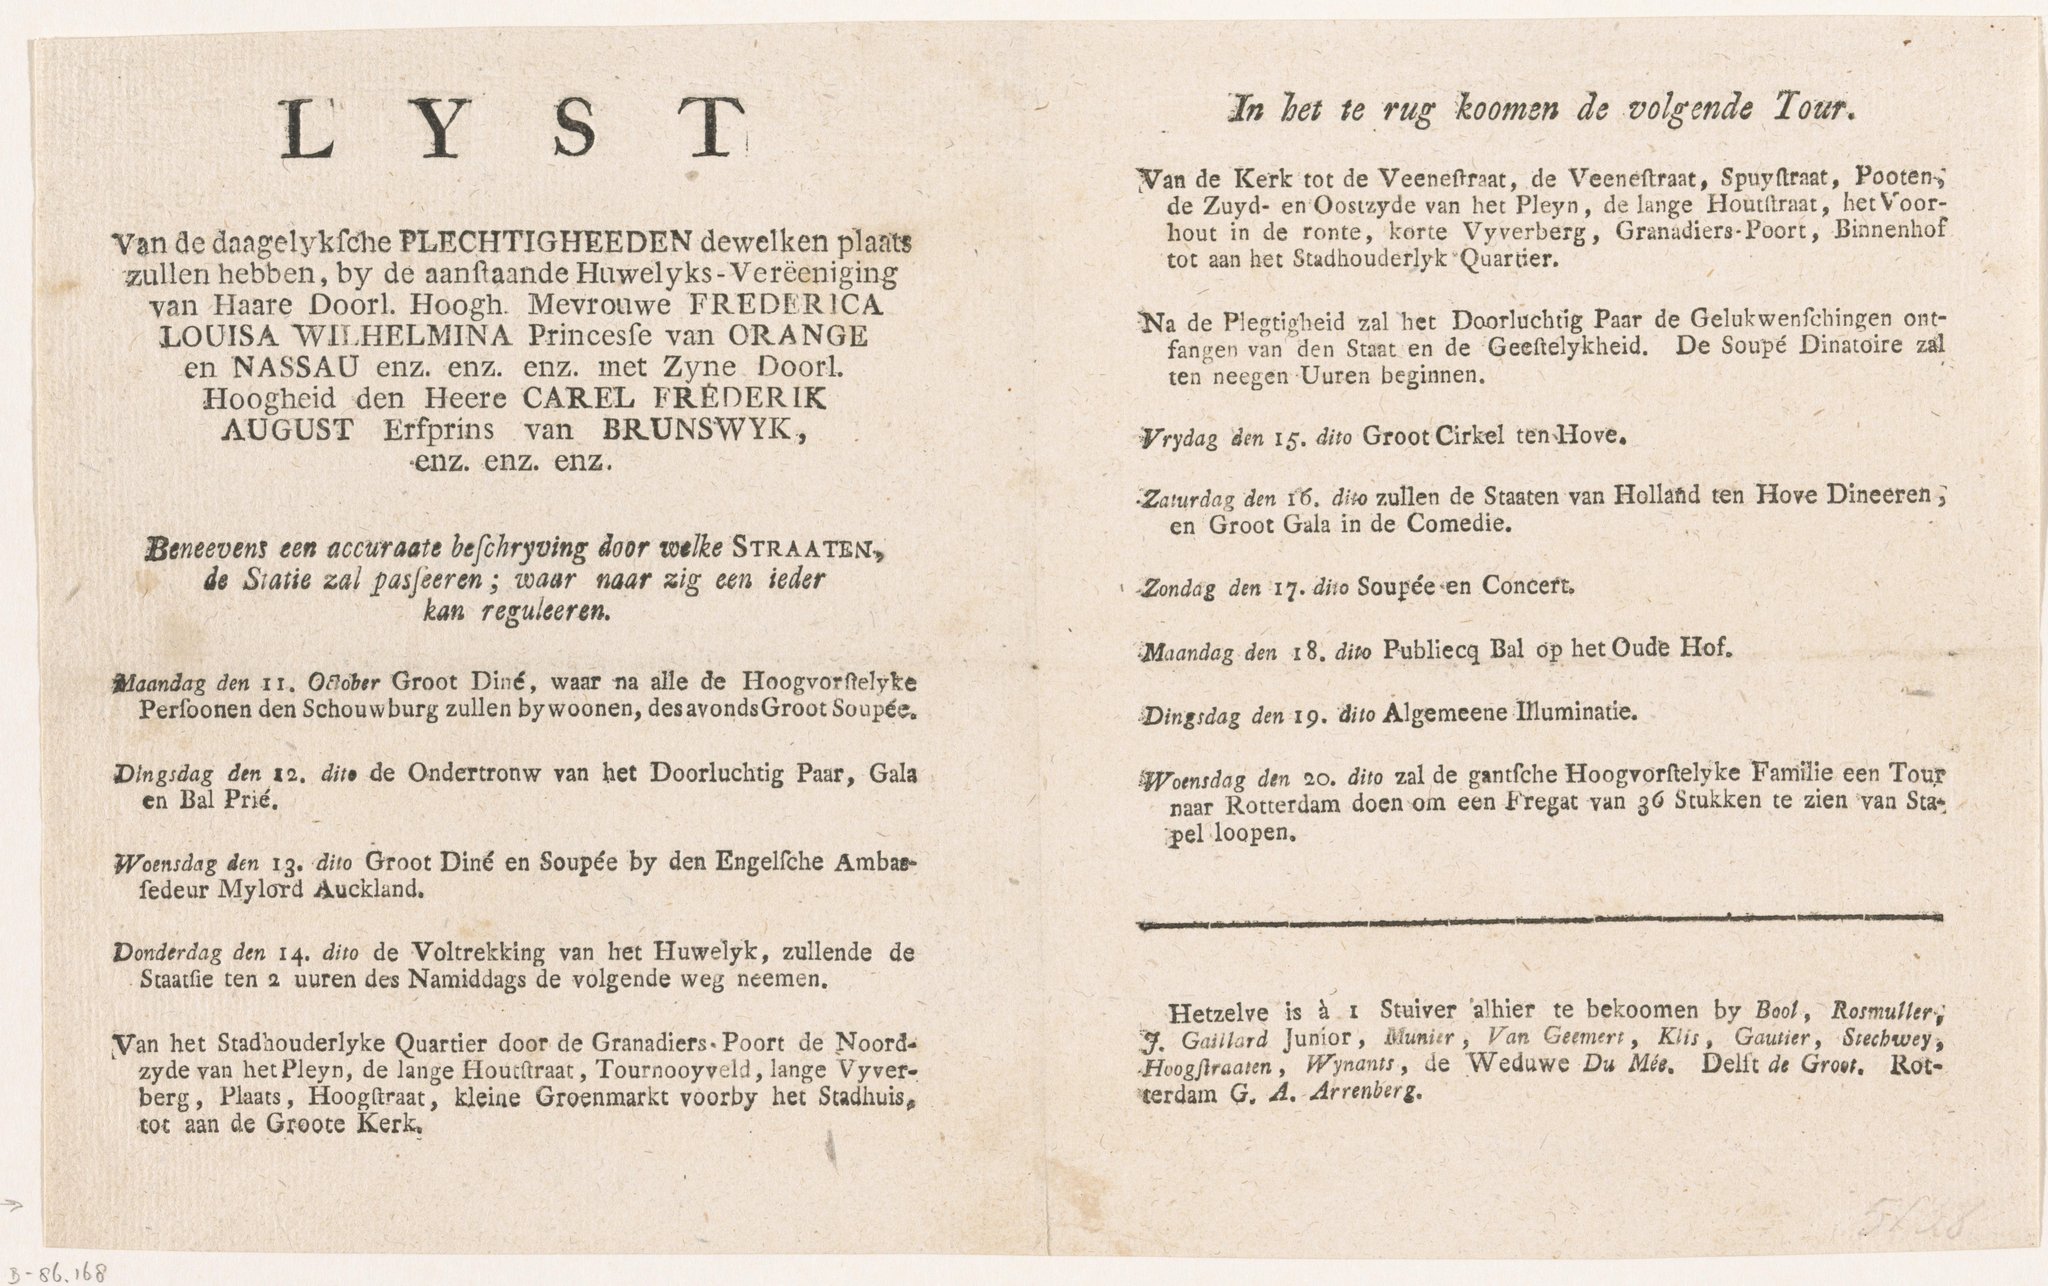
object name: text sheet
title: Programma van activiteiten rond het huwelijk van prinses Louise van Oranje-Nassau met Karel van Brunswijk-Wolfenbüttel, 1790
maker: Anonymous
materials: paper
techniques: letterpress printing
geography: the hague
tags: karel van brunswijk-wolfenbüttel, the hague, louise (prinses van oranje-nassau)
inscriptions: collector's mark: Lugt 2228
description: Tekstblad met een programma van activiteiten van tussen 11 en 20 oktober rond het huwelijk van prinses Louise van Oranje-Nassau met Karel van Brunswijk-Wolfenbüttel te Den Haag op 14 oktober 1790.